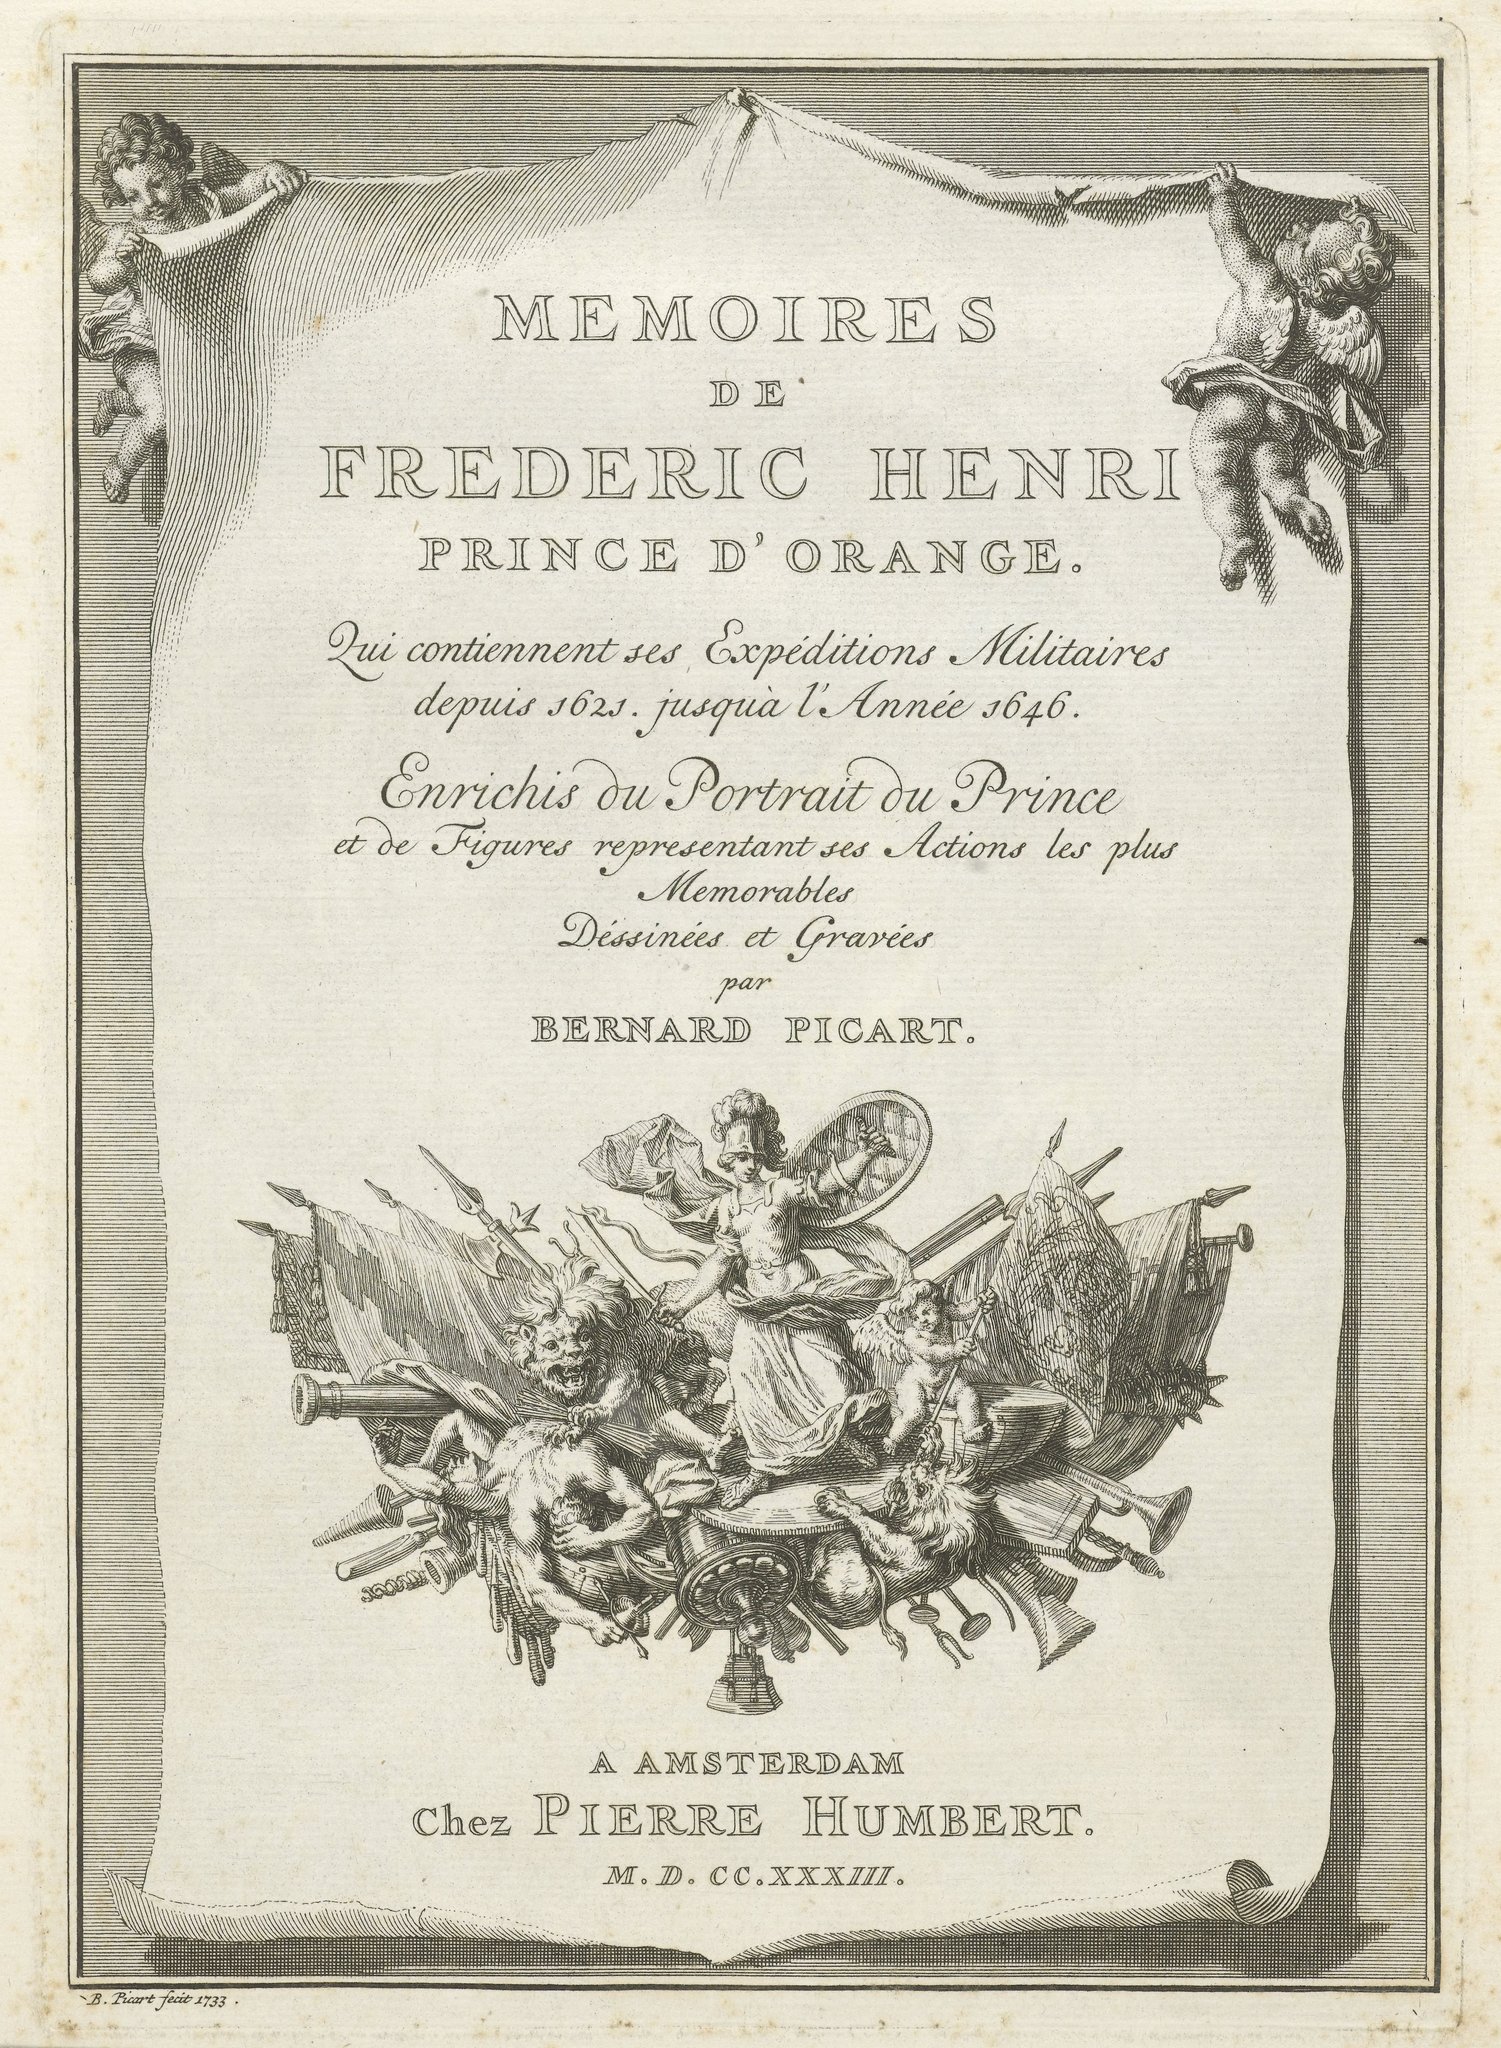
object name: titelprent, frontispice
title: Titelprent voor Memoires de Frederic Henri Prince d'Orange, 1621-1646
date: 1733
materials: paper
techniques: etching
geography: northern netherlands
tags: delft, the hague, frederick henry (prince of orange)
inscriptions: date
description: Ornamentale titelprent voor de uitgave van de Memoires de Frederic Henri Prince d'Orange, 1621-1646. Embleem met de personificatie van de strijdende Overwinning met de Nederlandse Leeuw tussen wapentuig, vaandels en verslagen vijand.